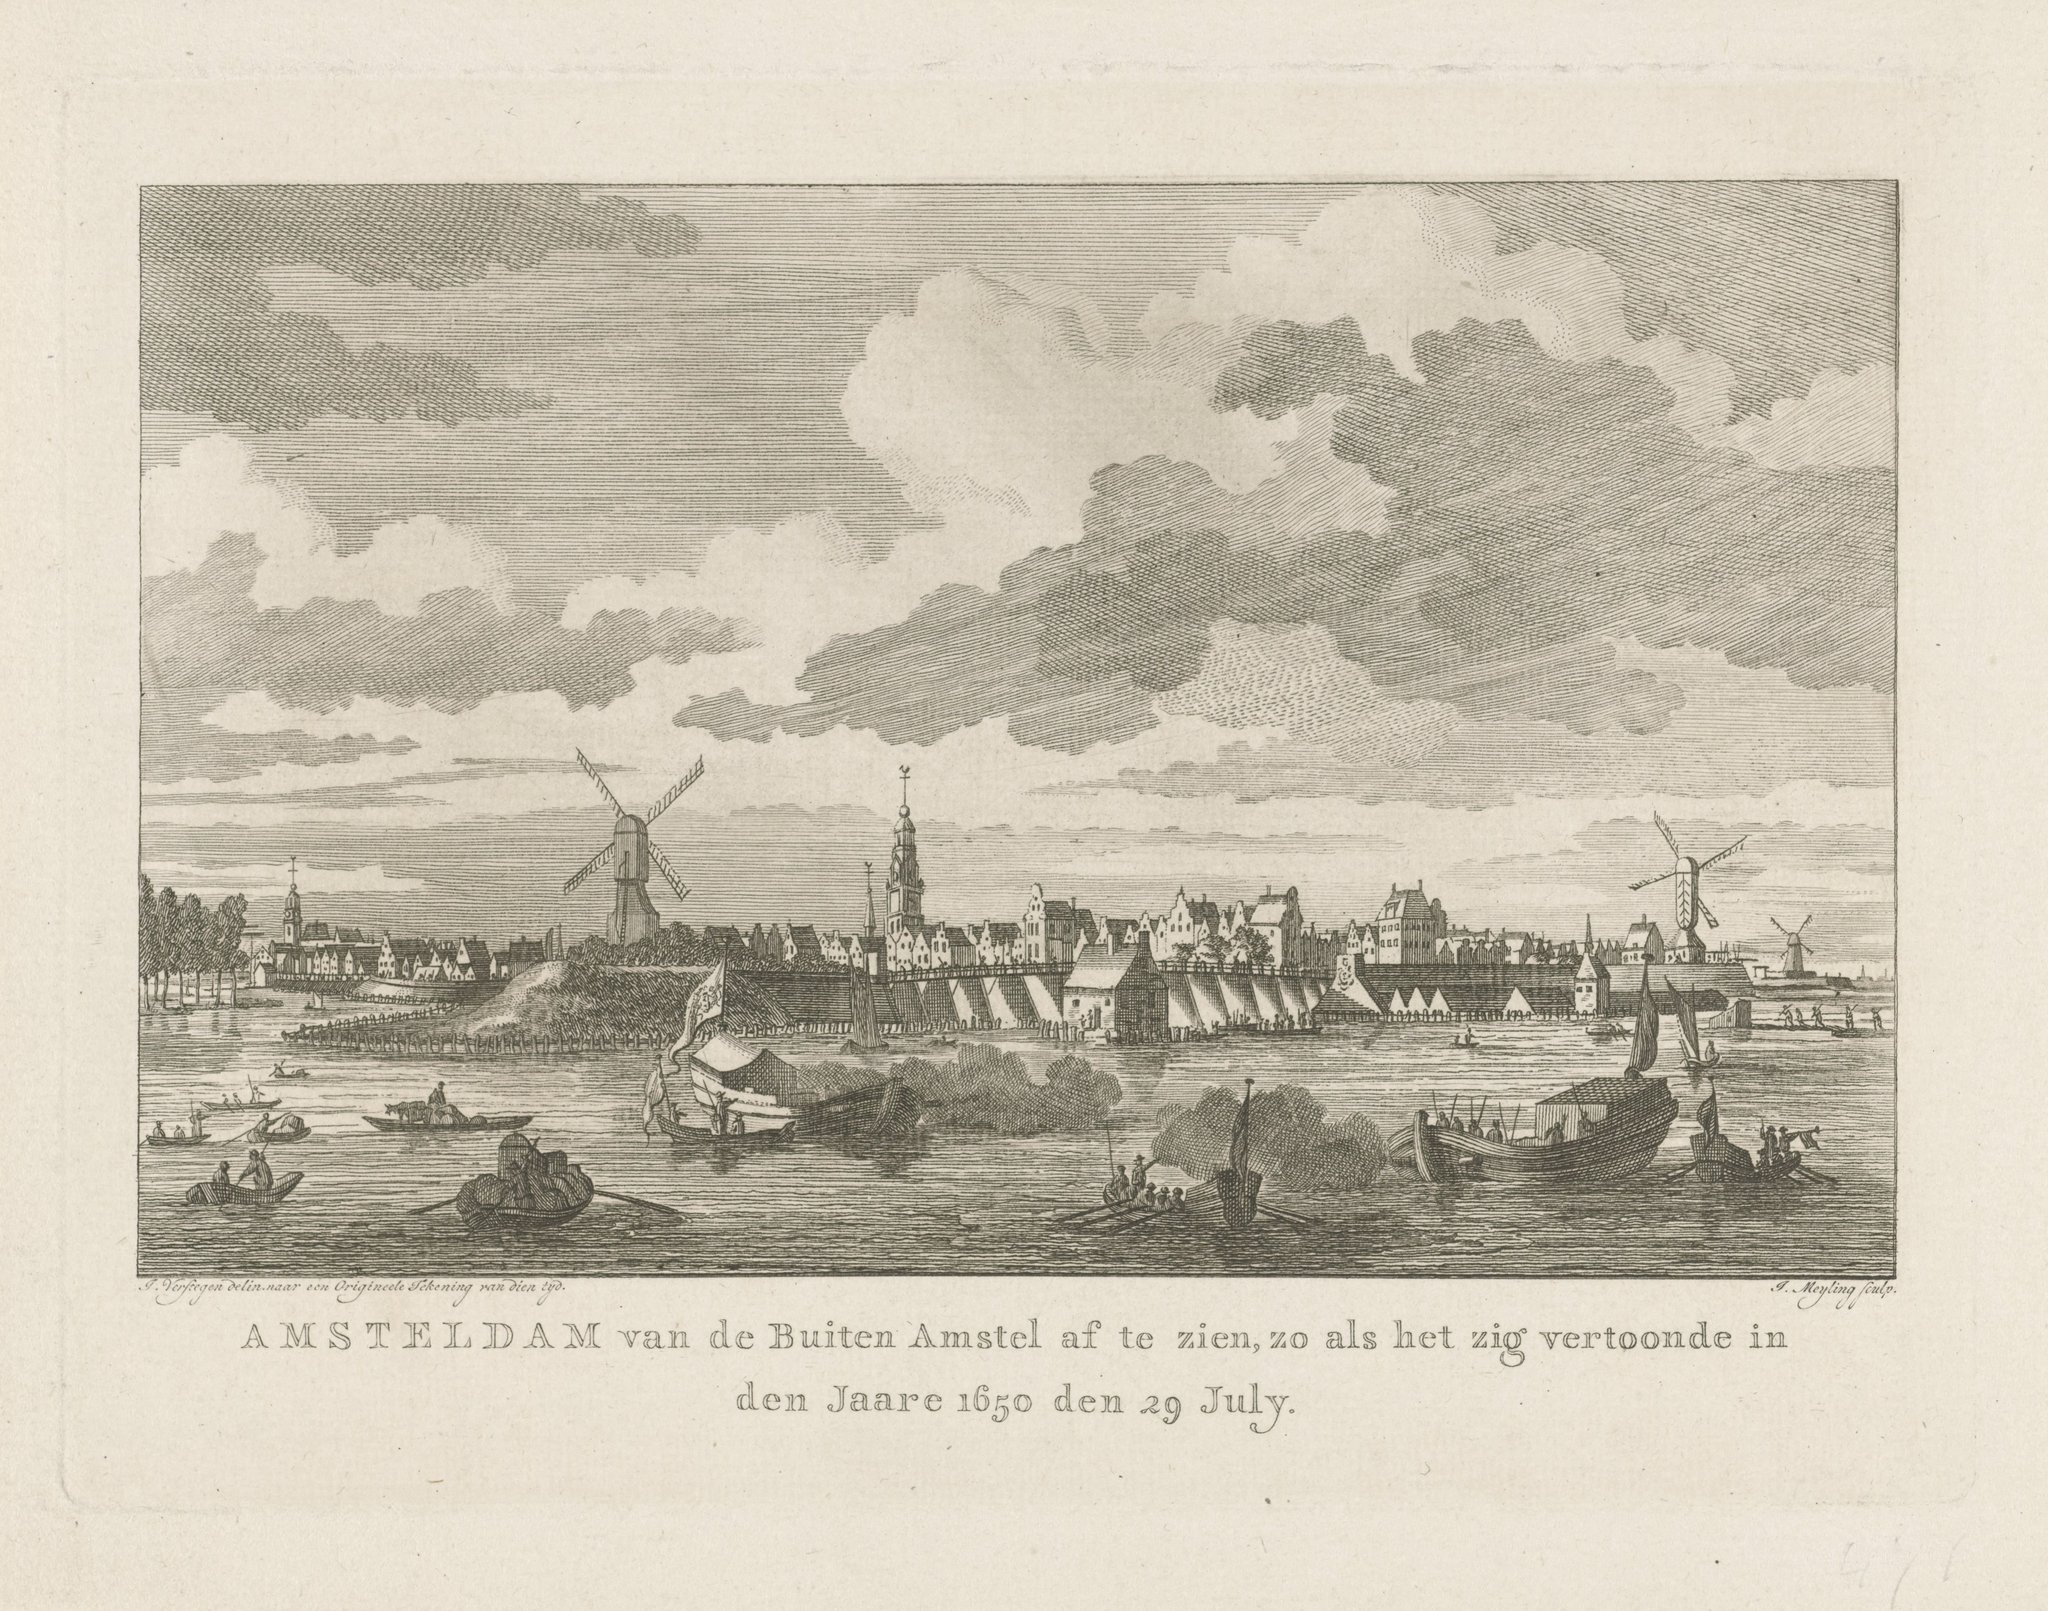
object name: history print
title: Amsteldam van de Buiten Amstel af te zien, zo als het zig vertoonde in den jaare 1650 den 29 july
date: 1750-1800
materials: paper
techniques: engraving, etching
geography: amsterdam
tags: william ii (prince of orange), rowing-boat, canoe, etc., city-walls, prospect of city, town panorama, silhouette of city, amsterdam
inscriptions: collector's mark: Lugt 2228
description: Gezicht op Amsterdam, gezien vanaf de Buiten-Amstel, zonder de Blokhuizen, 29 juli 1650 (rond de Aanslag op Amsterdam). Met verschillende bootjes (met soldaten of schutters?) op het water. Op de achtergrond de Blauwbrug en de toren van de Zuiderkerk.